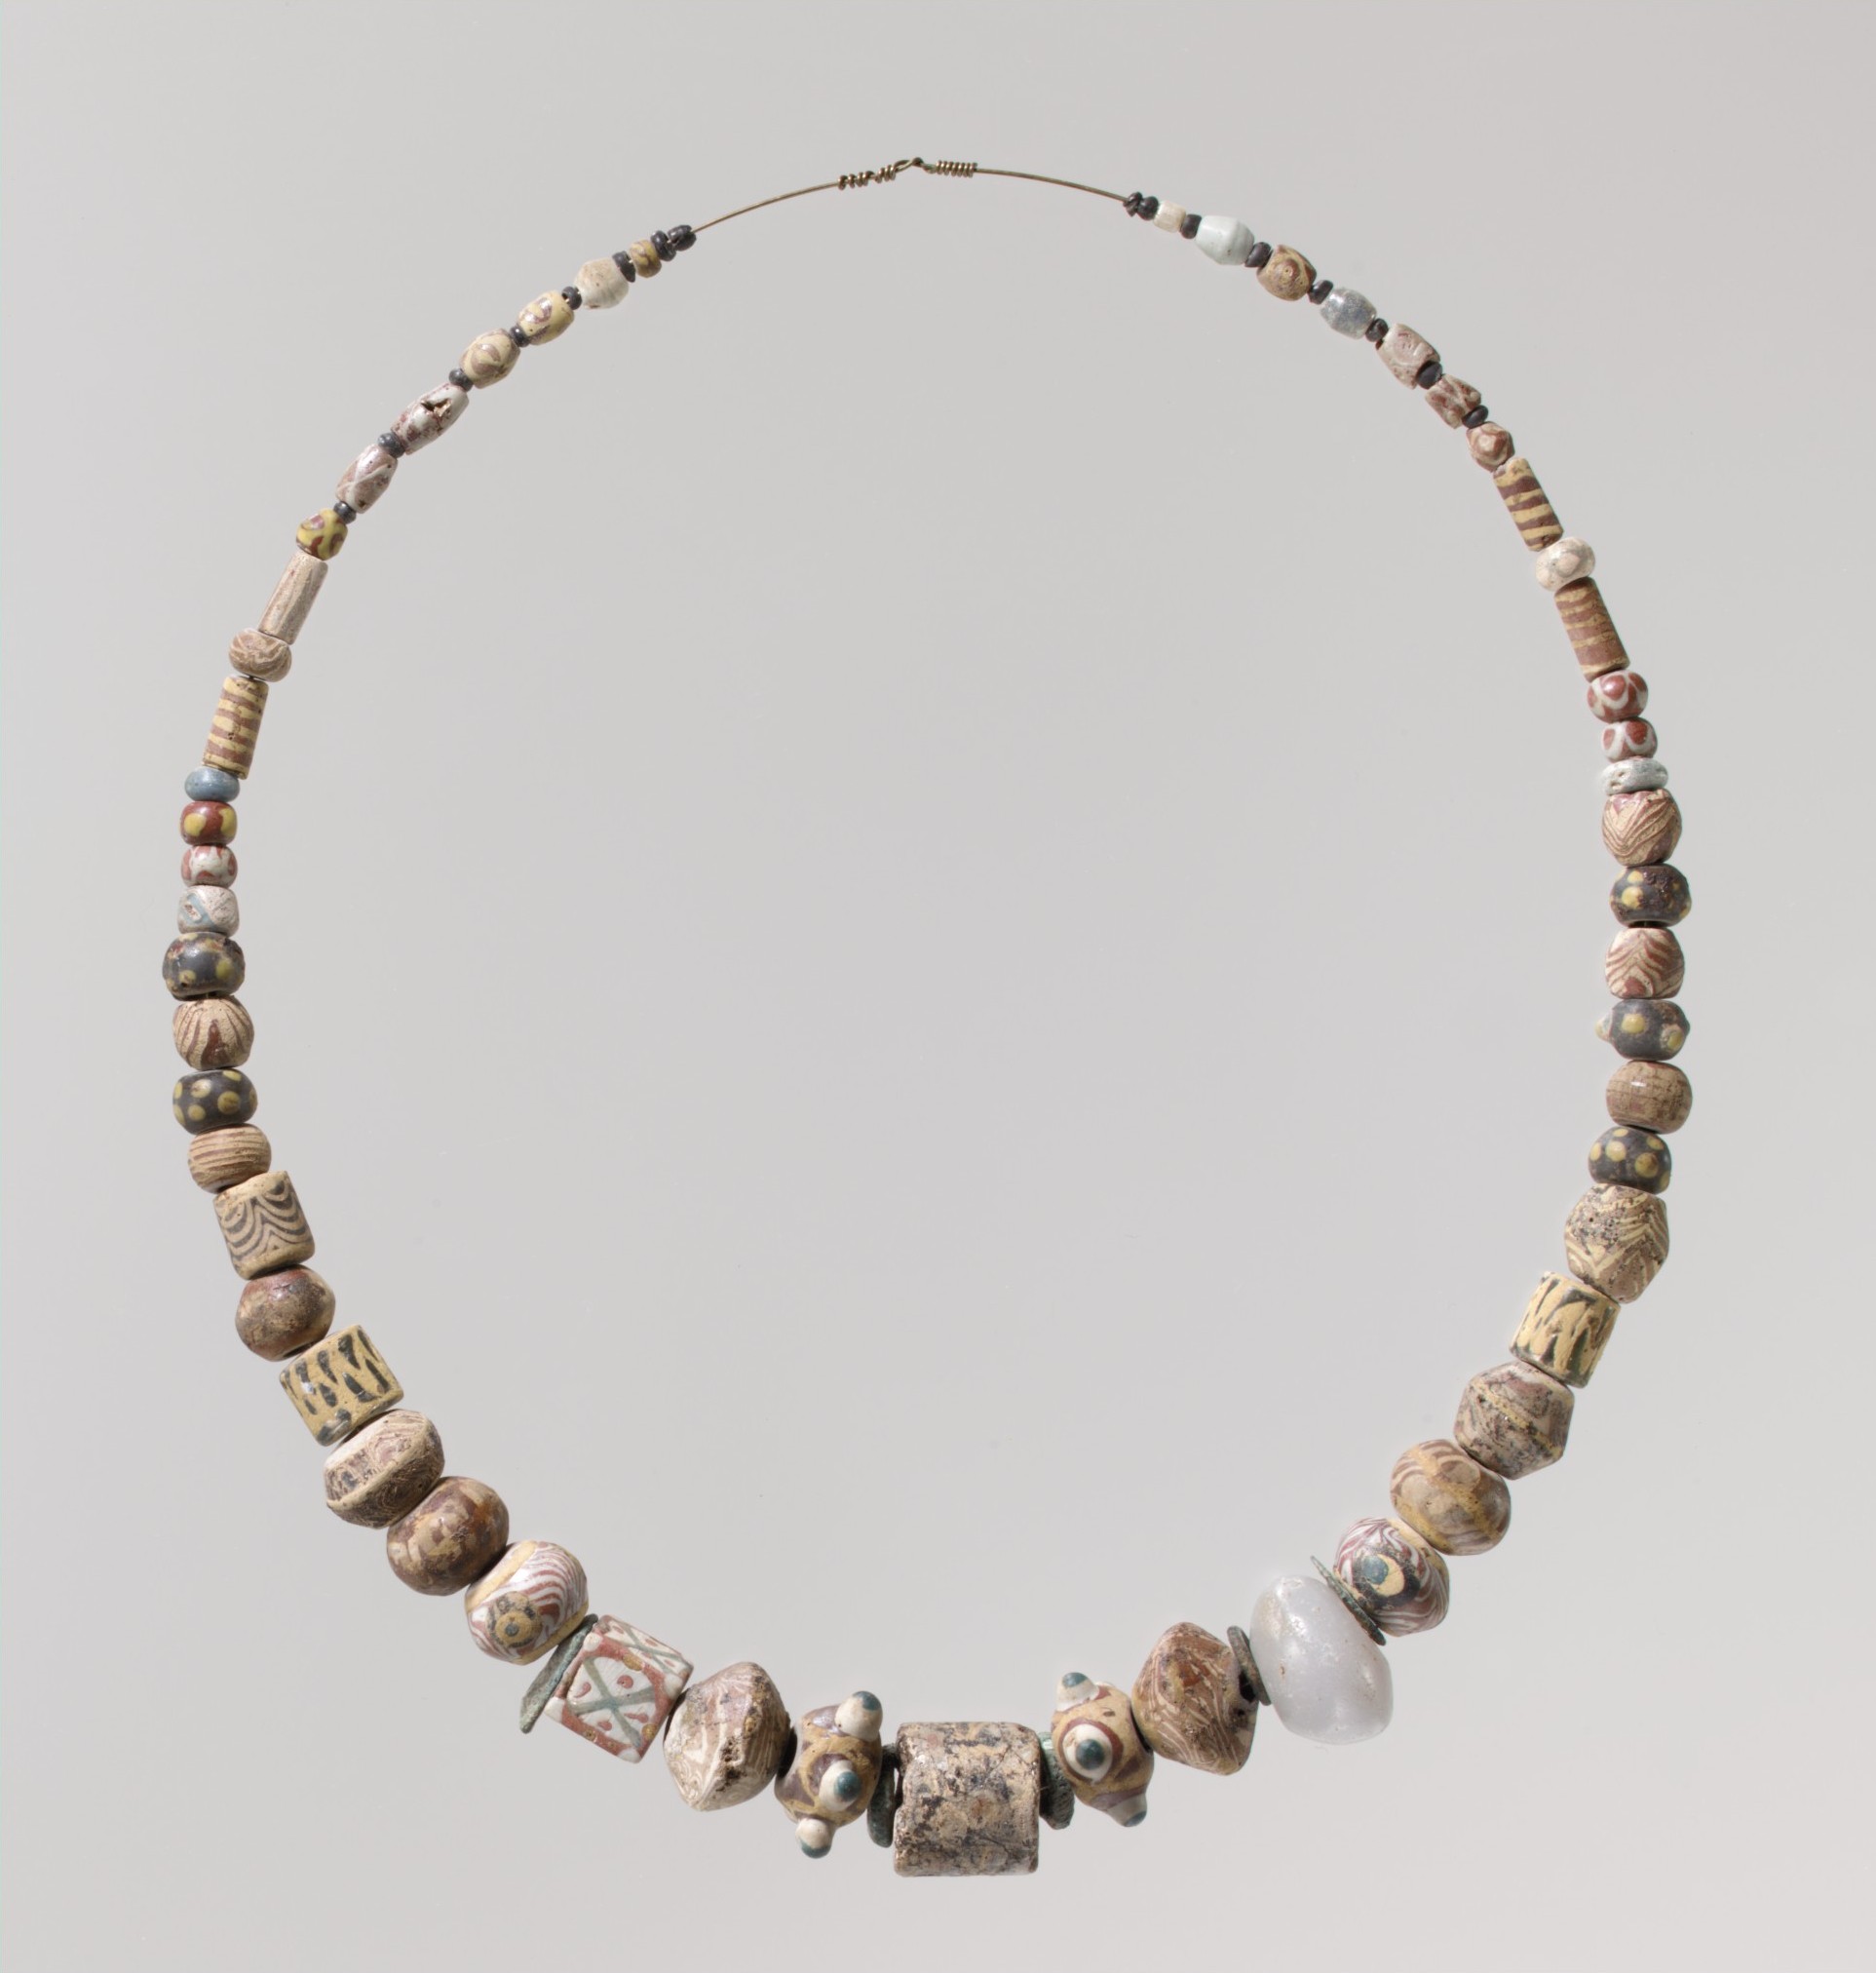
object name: necklace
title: Beads from a Necklace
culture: frankish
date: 501-600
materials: copper alloy, glass